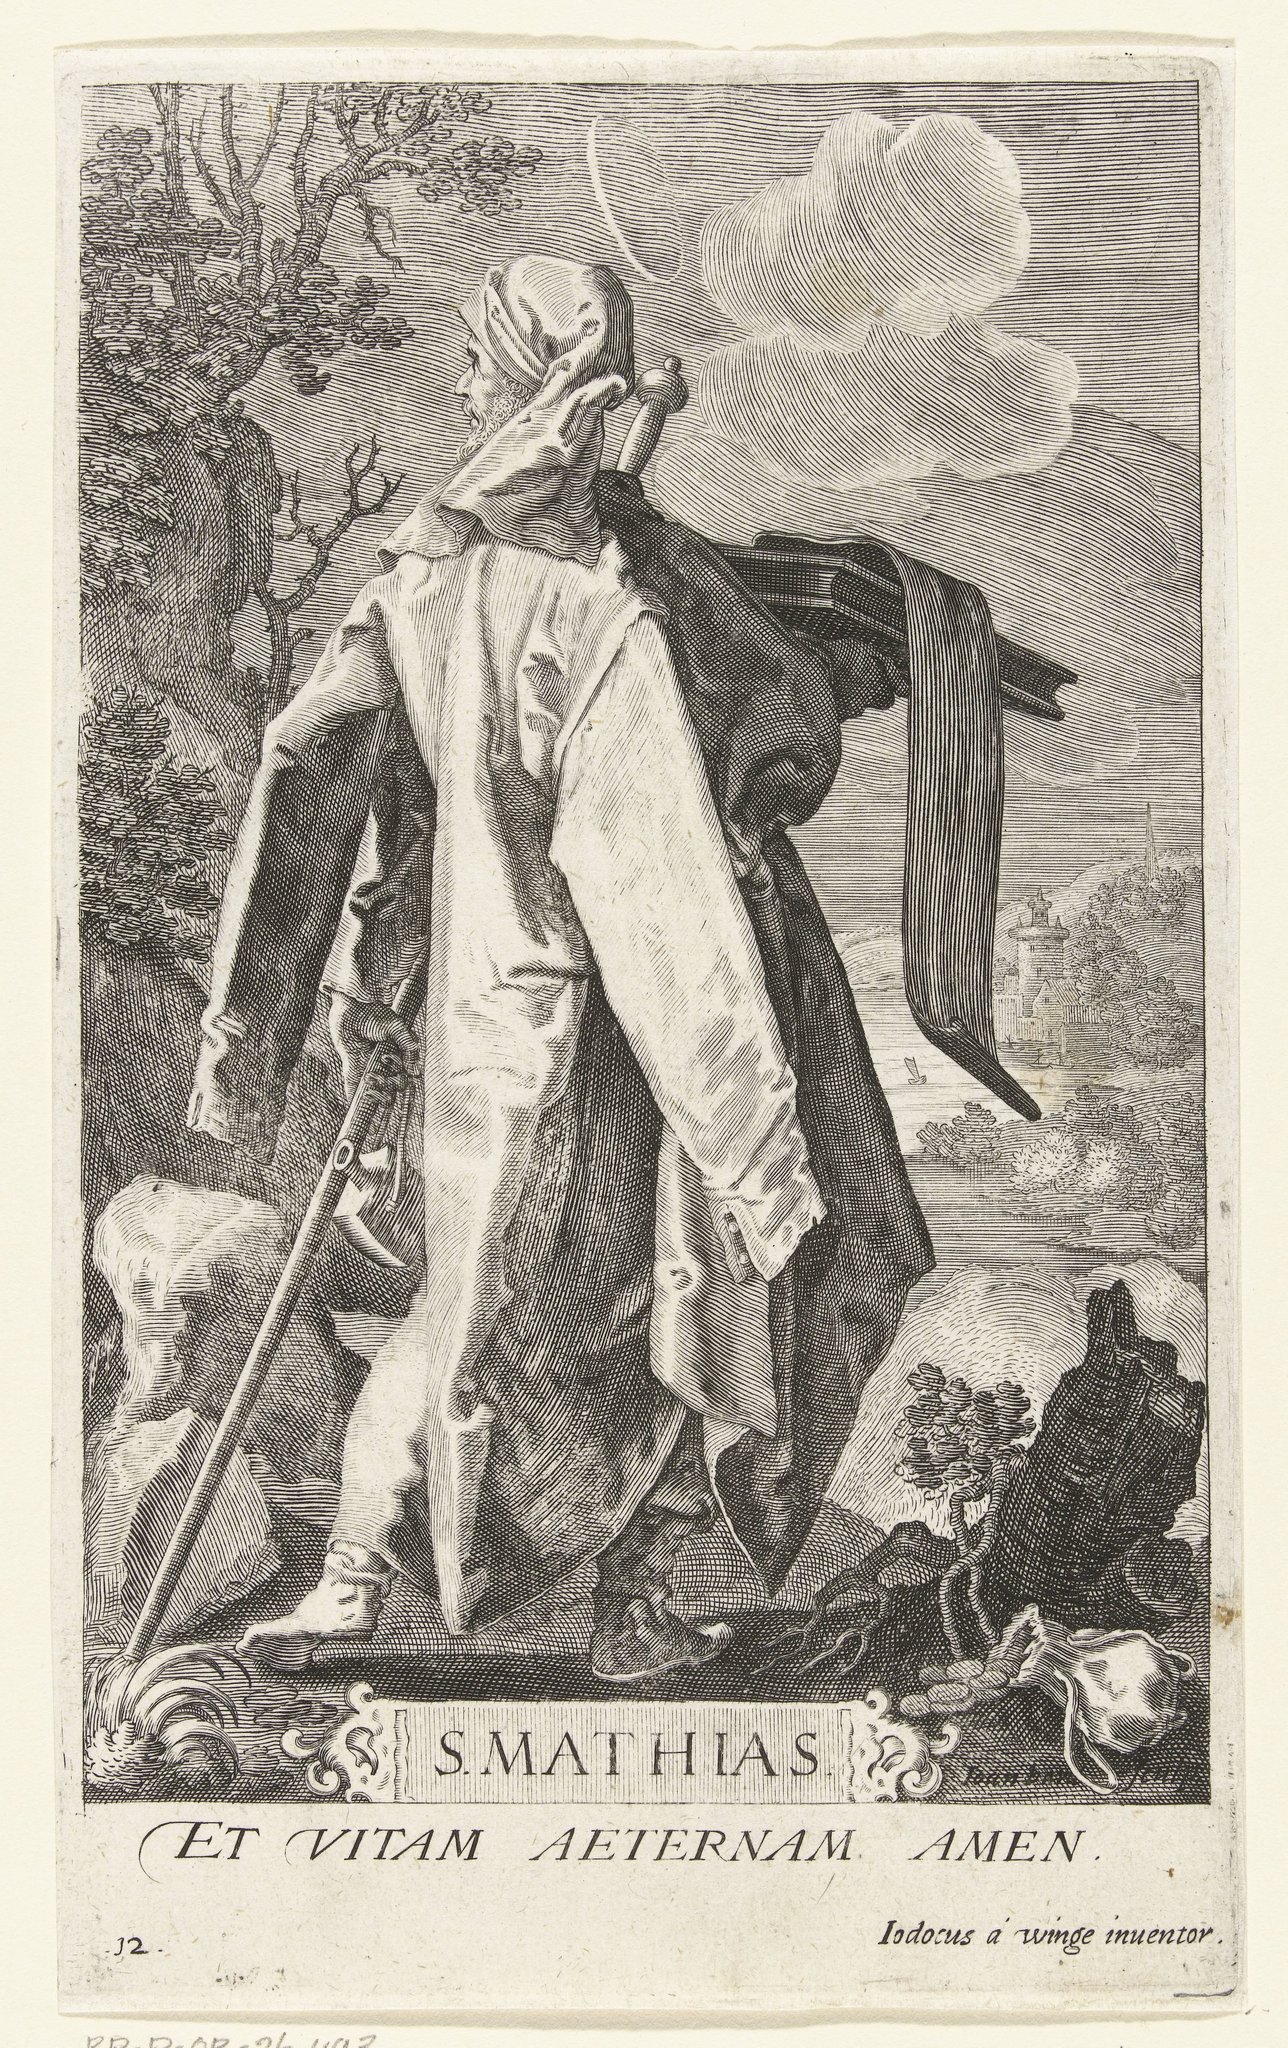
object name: print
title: Apostel Mattias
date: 1591-1629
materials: paper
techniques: engraving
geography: prague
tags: the apostle and martyr matthias; possible attributes: axe, book, cross, halberd, scroll, sword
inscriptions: collector's mark: Lugt 2228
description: Prent naar ontwerp van Joos van Winghe. Prent maakt deel uit van serie met dertien prenten en titelprent van Christus en twaalf apostelen.